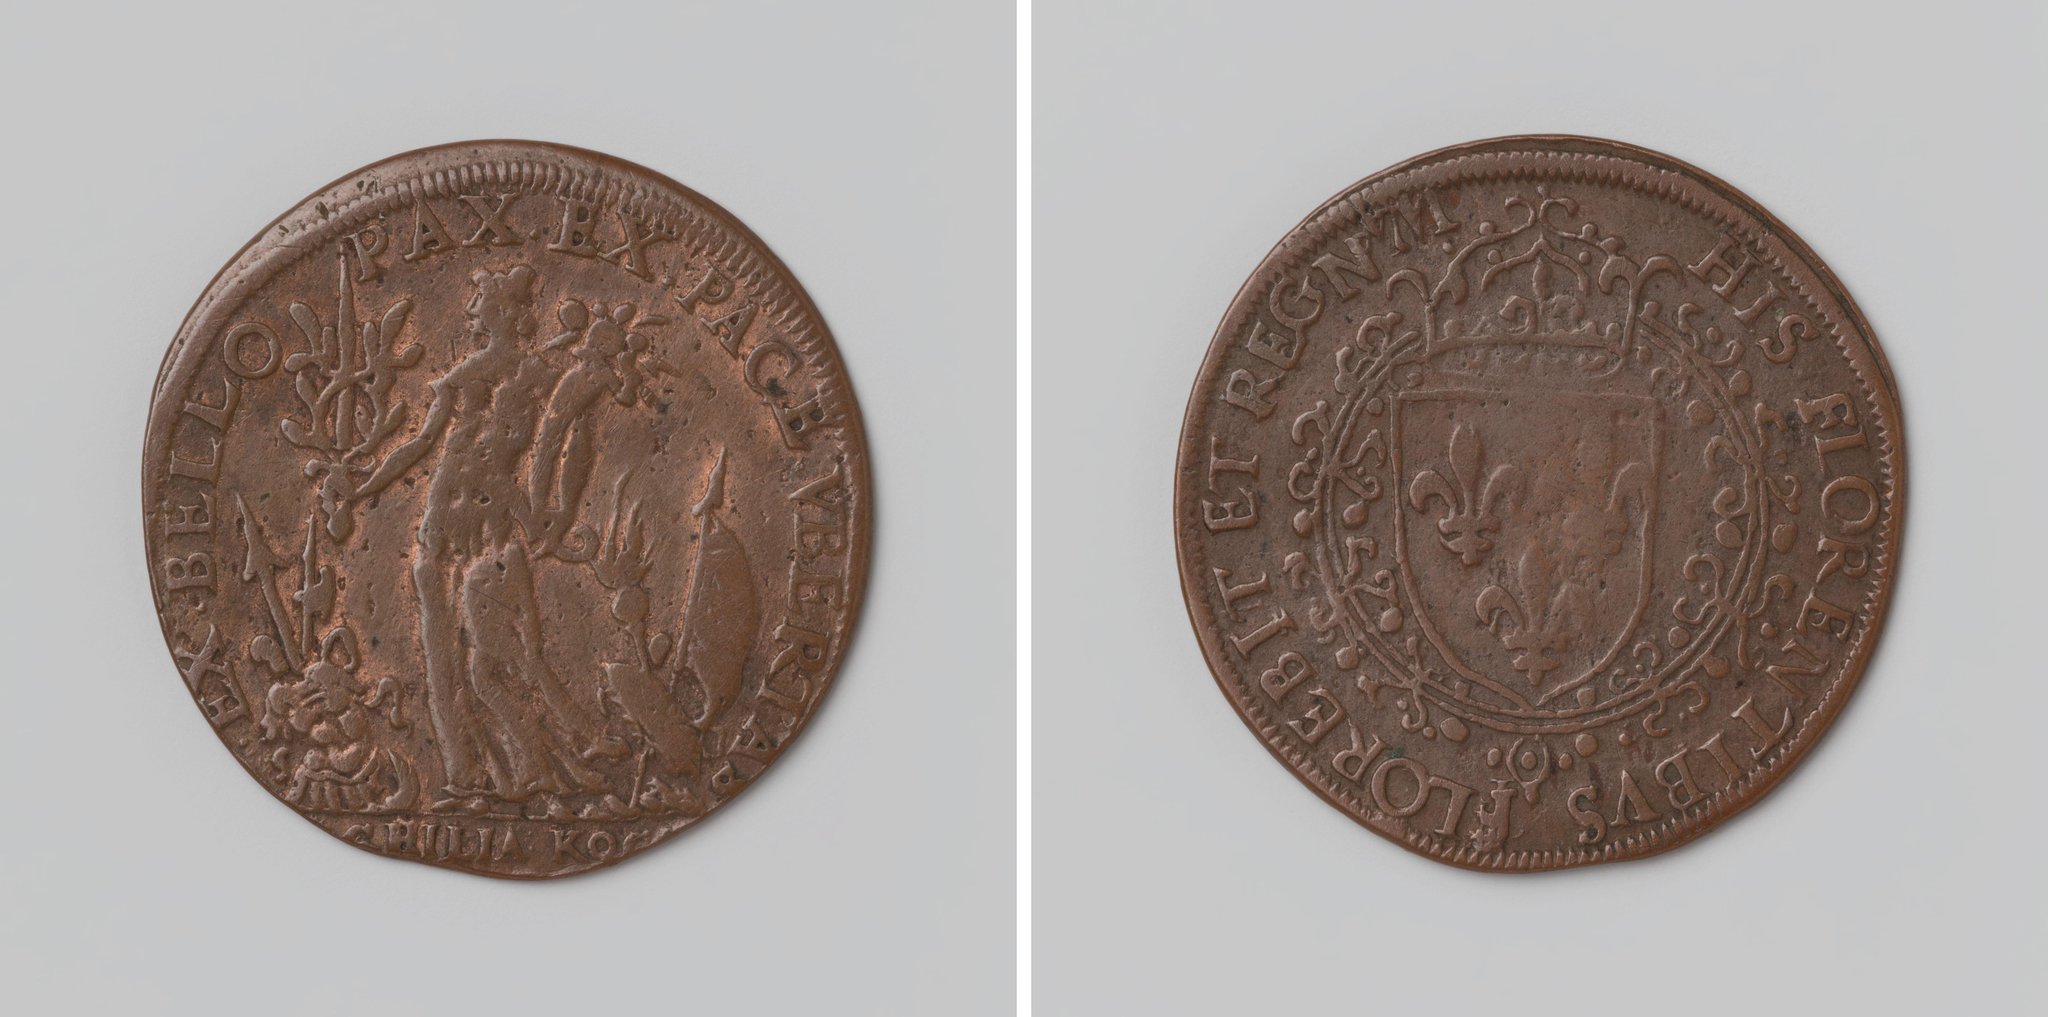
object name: jeton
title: Vrede van Vervins tussen Frankrijk en Spanje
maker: chilia koch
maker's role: medailleur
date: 1598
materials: copper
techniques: striking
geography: nuremberg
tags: france, spain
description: Koperen penning. Voorzijde: Vrede met gevulde hoorn van overvloed in linker- en met olijftak versierd zwaard in rechterhand staande temidden van wapentropheen binnen omschrift; afsnede: opschrift. Keerzijde: gekroond wapenschild in versierd cartouche binnen omschrift.